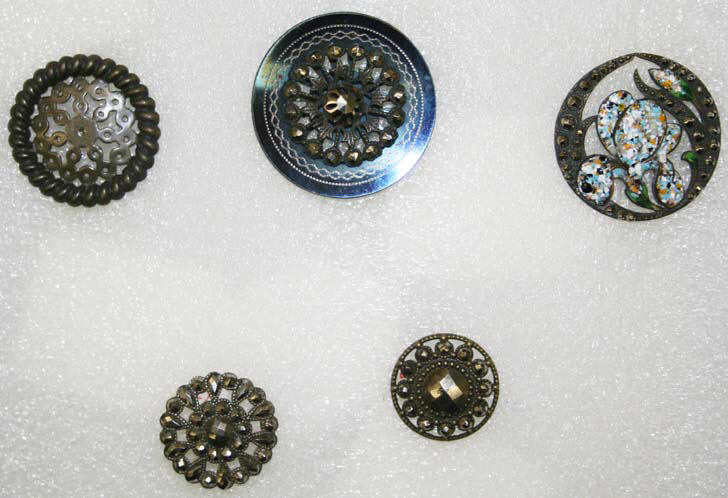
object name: button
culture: american or european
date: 1850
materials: metal